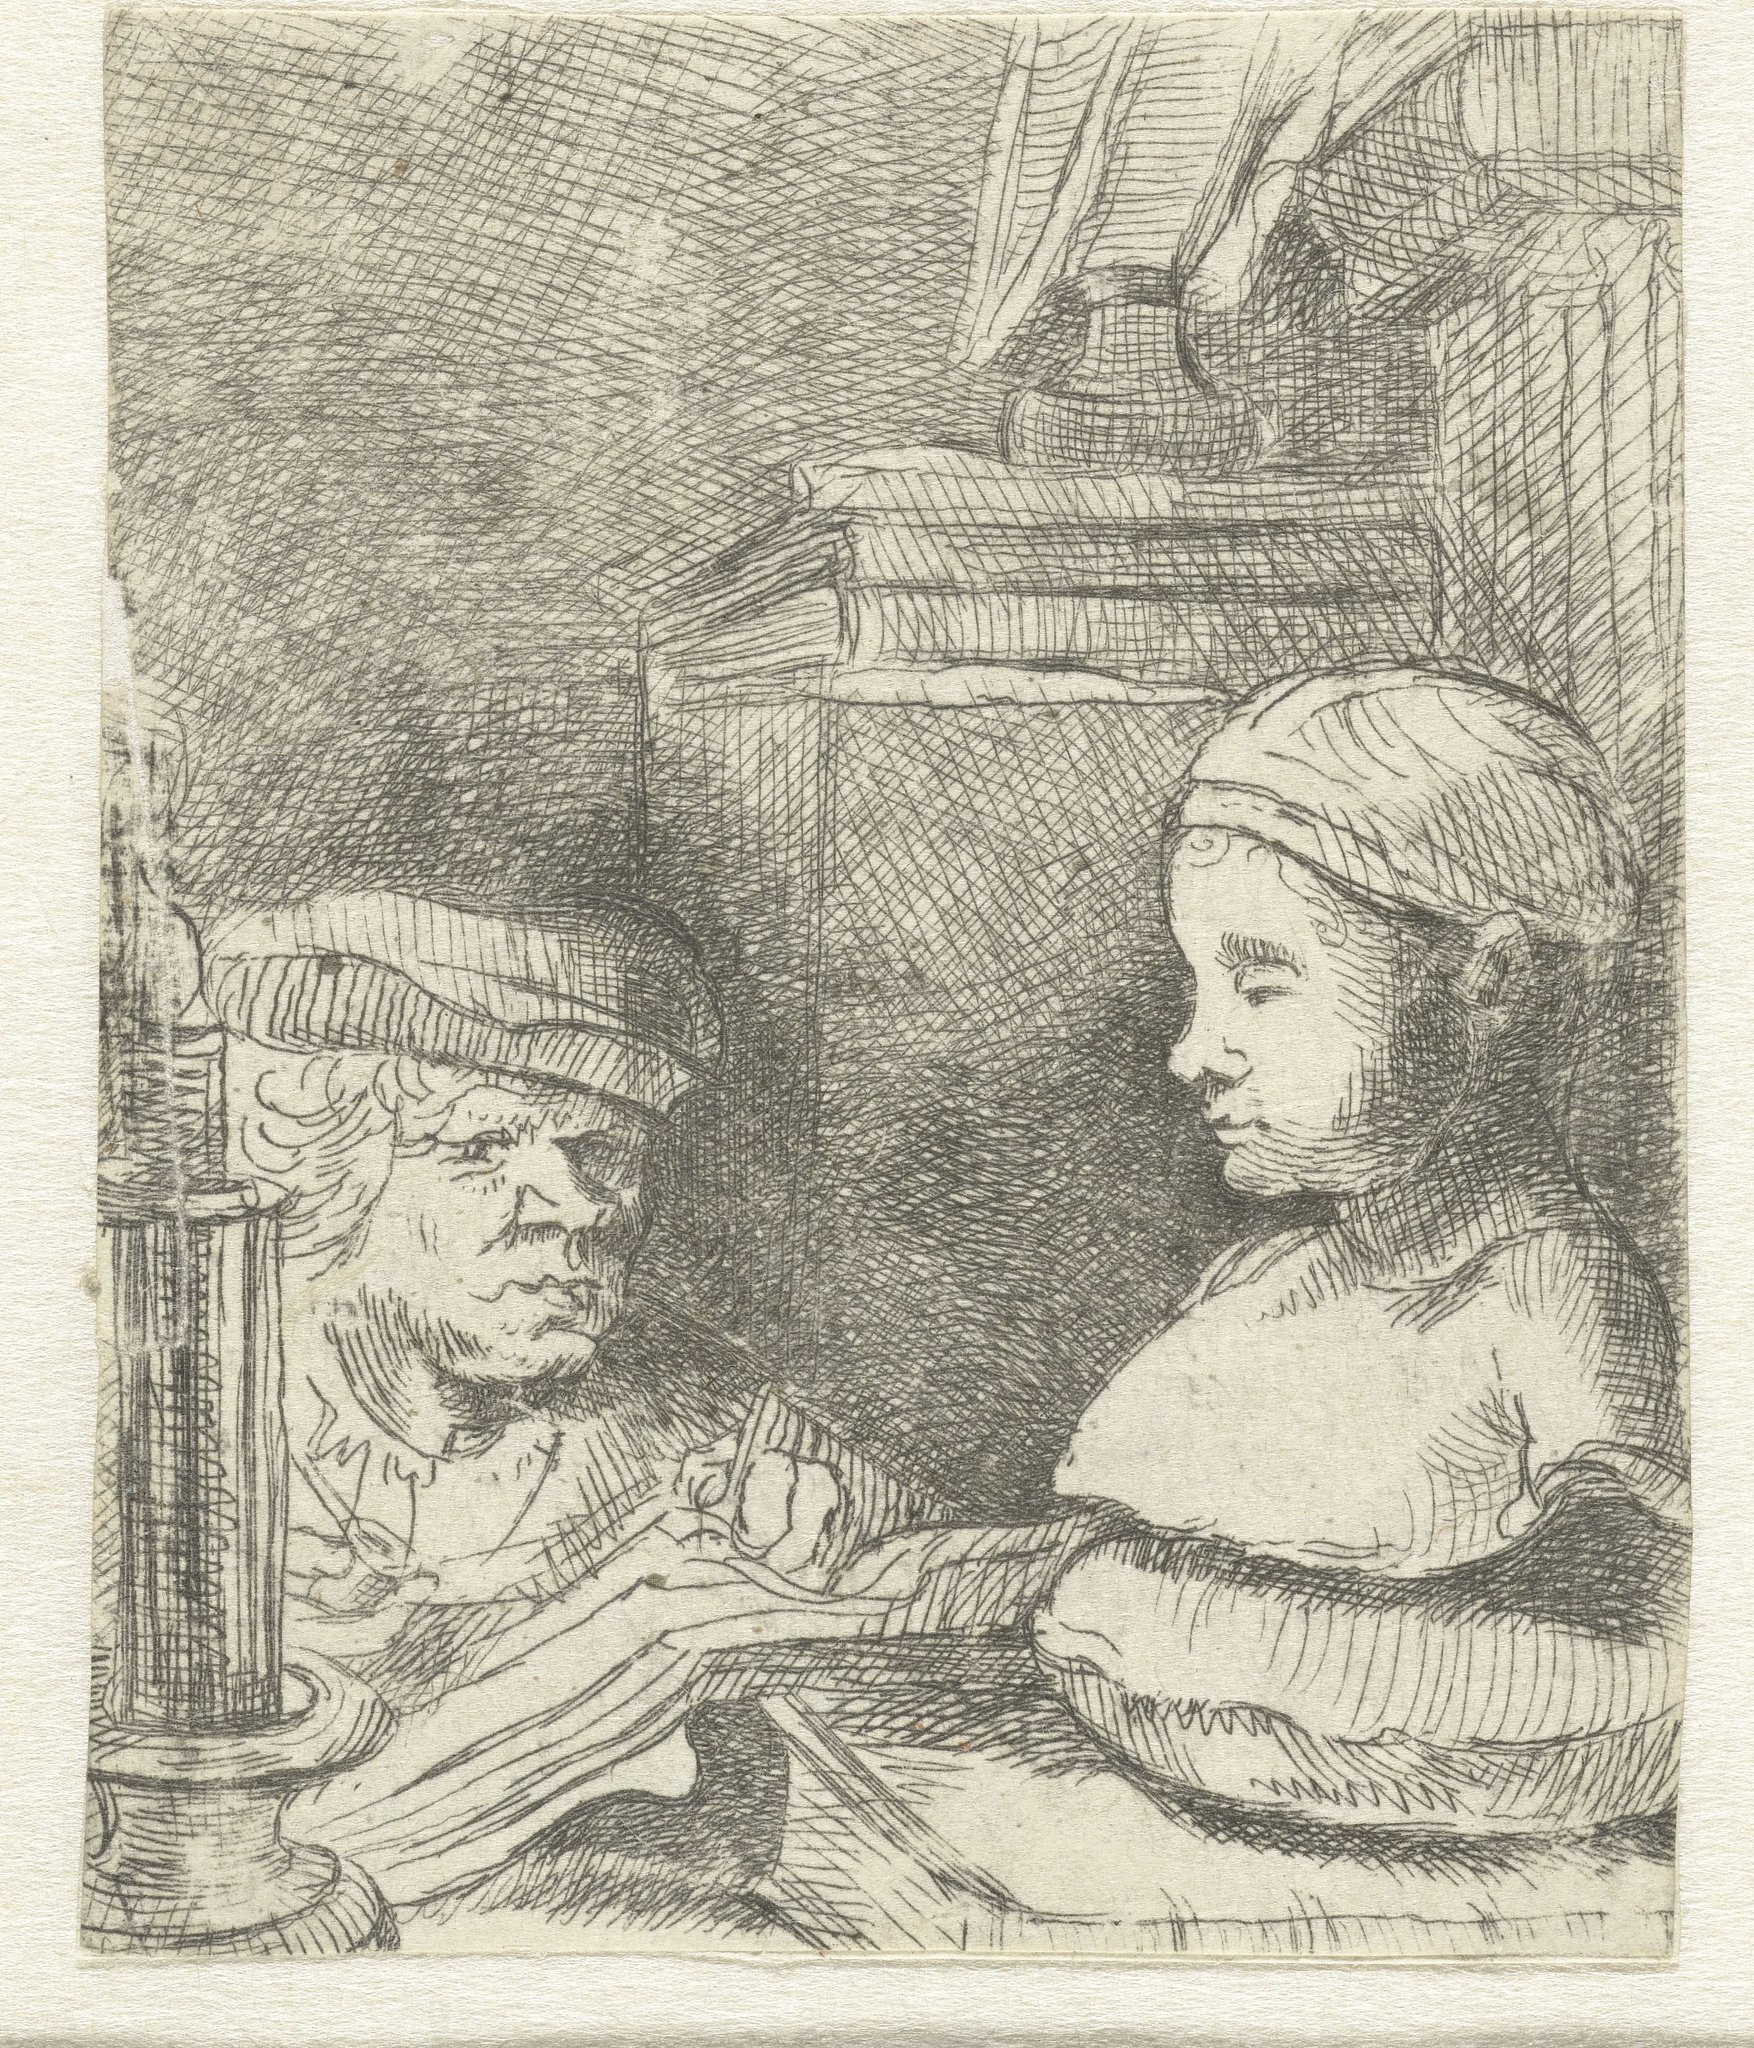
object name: print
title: Man drawing from a cast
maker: Anonymous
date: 1641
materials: paper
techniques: etching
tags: drawing, art (+ artist studying classical remains)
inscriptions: collector's mark: Lugt 240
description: Spiegelbeeldige kopie naar de gelijknamige prent van Rembrandt.